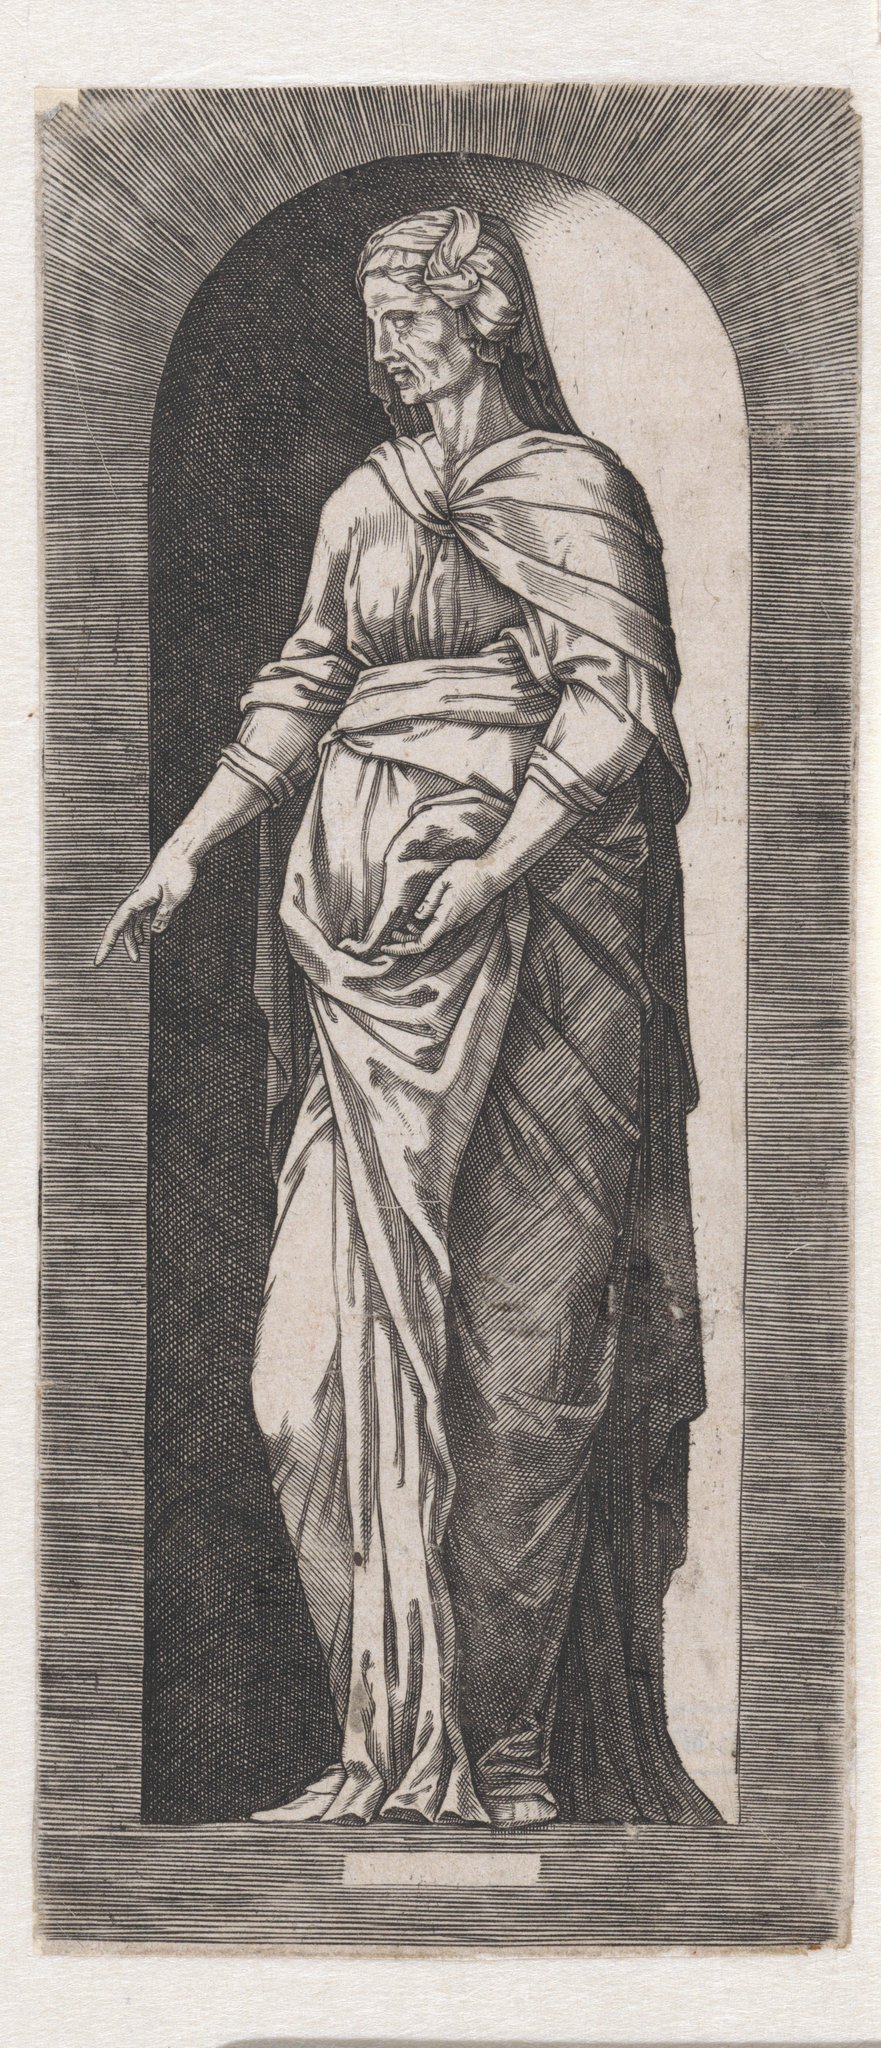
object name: print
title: Sibillen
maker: lambertus suavius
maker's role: print maker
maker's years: 1514-1564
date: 1520-1567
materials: paper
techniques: engraving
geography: southern netherlands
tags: sibyls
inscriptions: collector's mark: Lugt 2228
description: Een oudere Sibille, staande in een nis, wijst met haar rechterhand.